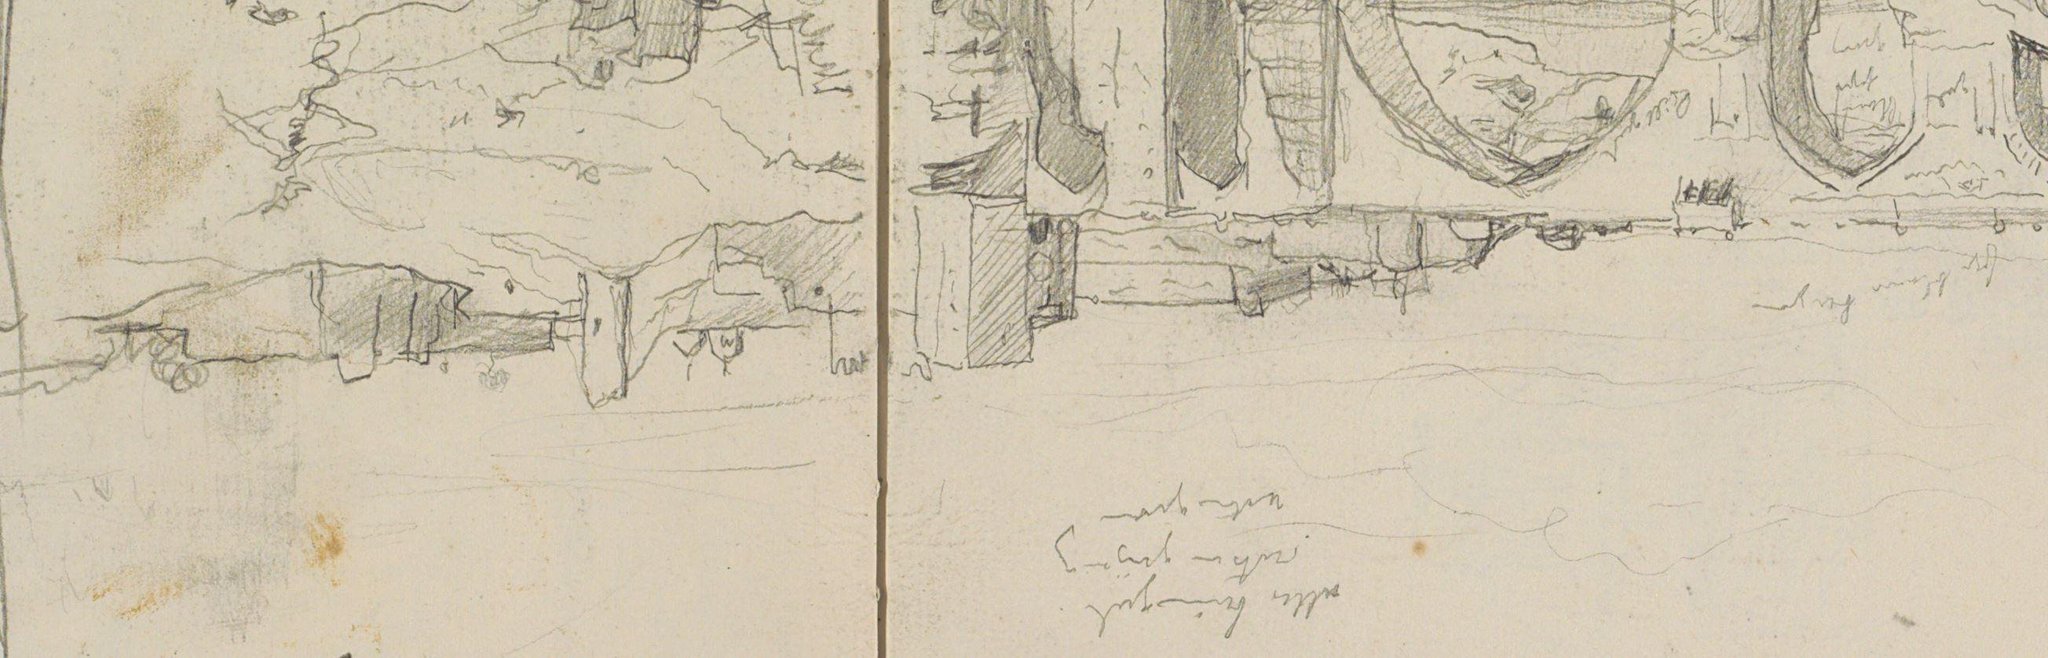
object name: sketchbook leaf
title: Gezicht op de Alcántara brug over de Taag in Toledo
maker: marius bauer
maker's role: draughtsman, print maker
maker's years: 1867-1932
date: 1902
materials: paper, pencil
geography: toledo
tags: city-view, and landscape with man-made constructions, bridge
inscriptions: annotation: ‘Toledo’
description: Pagina 28 en 29 uit een schetsboek met 30 bladen.